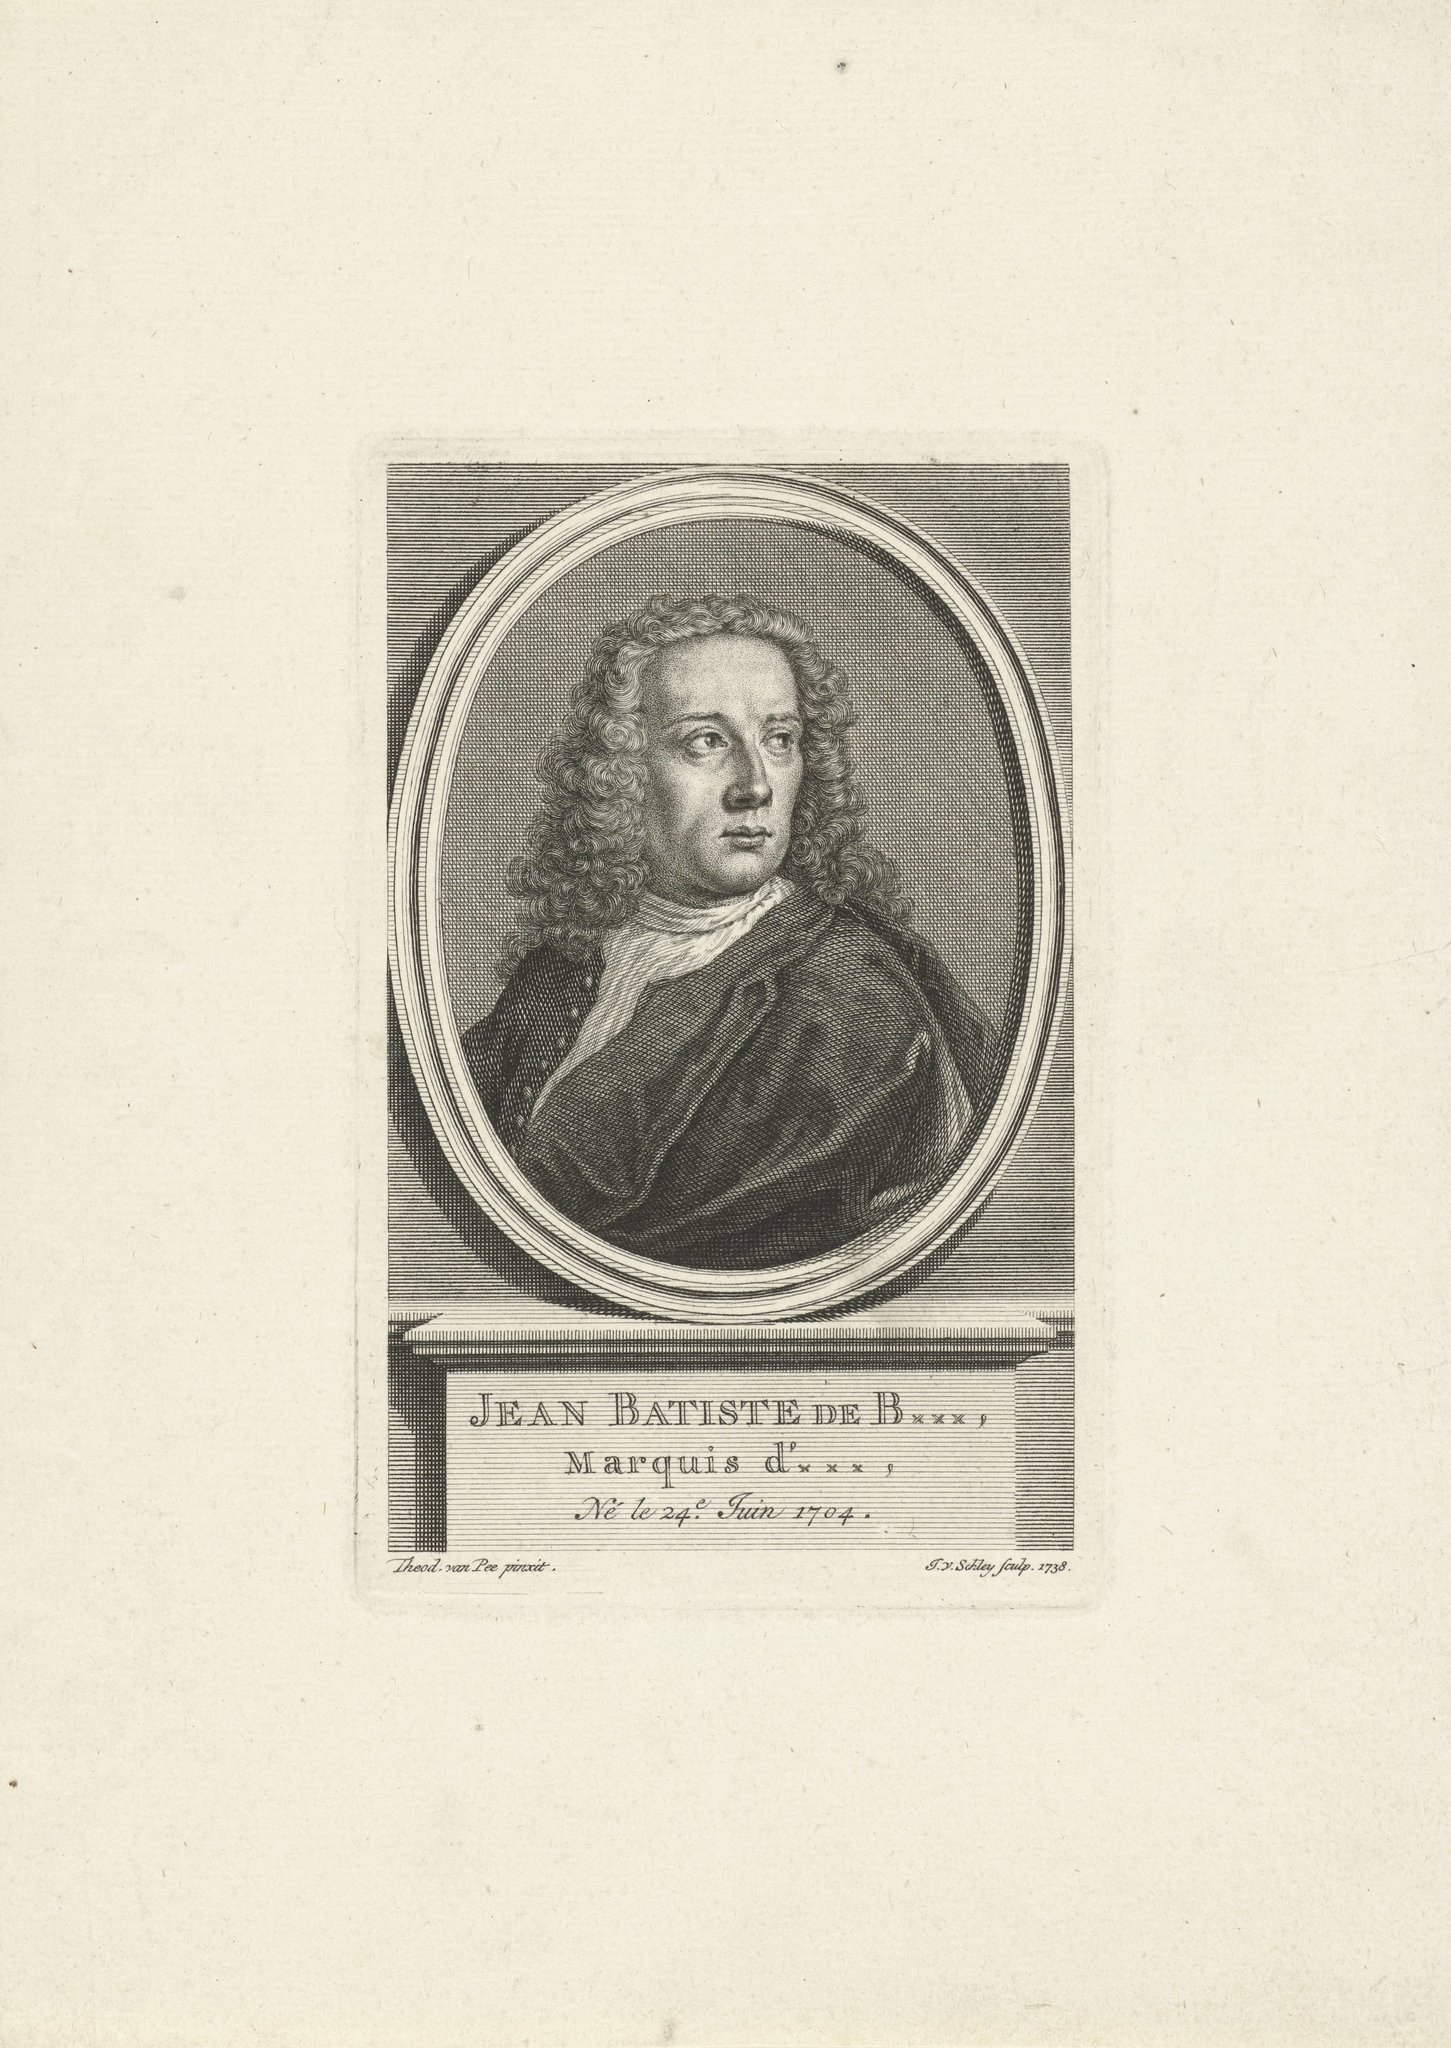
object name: print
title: Portret van Jean-Baptiste de Boyer, Marquis d'Argens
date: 1738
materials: paper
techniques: engraving, etching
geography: amsterdam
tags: wig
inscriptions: collector's mark: Lugt 2228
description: Ook gebruikt als illustratie in: Jean-Baptiste de Boyer marquis d' Argens. Lettres juives ou Correspondance philosophique, Den Haag: Pierre Paupie, 1738.